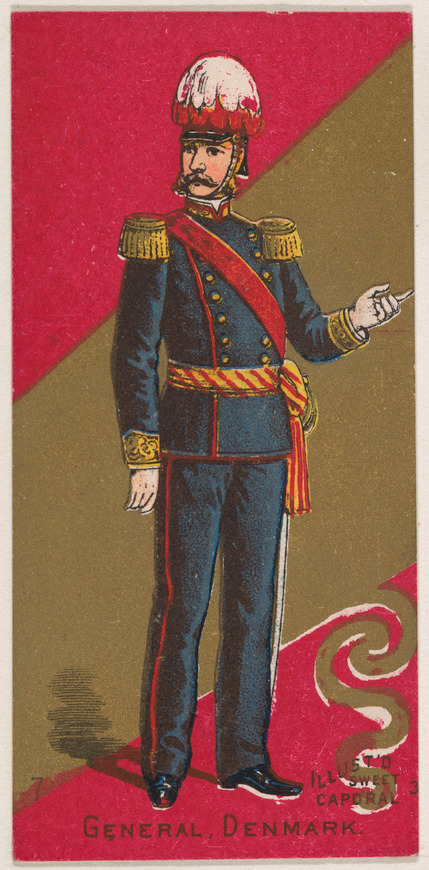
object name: print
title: General, Denmark, from the Military Series (N224) issued by Kinney Tobacco Company to promote Sweet Caporal Cigarettes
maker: kinney brothers tobacco company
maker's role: publisher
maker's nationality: american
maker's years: 1869-2011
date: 1888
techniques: color lithograph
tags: military,men,generals